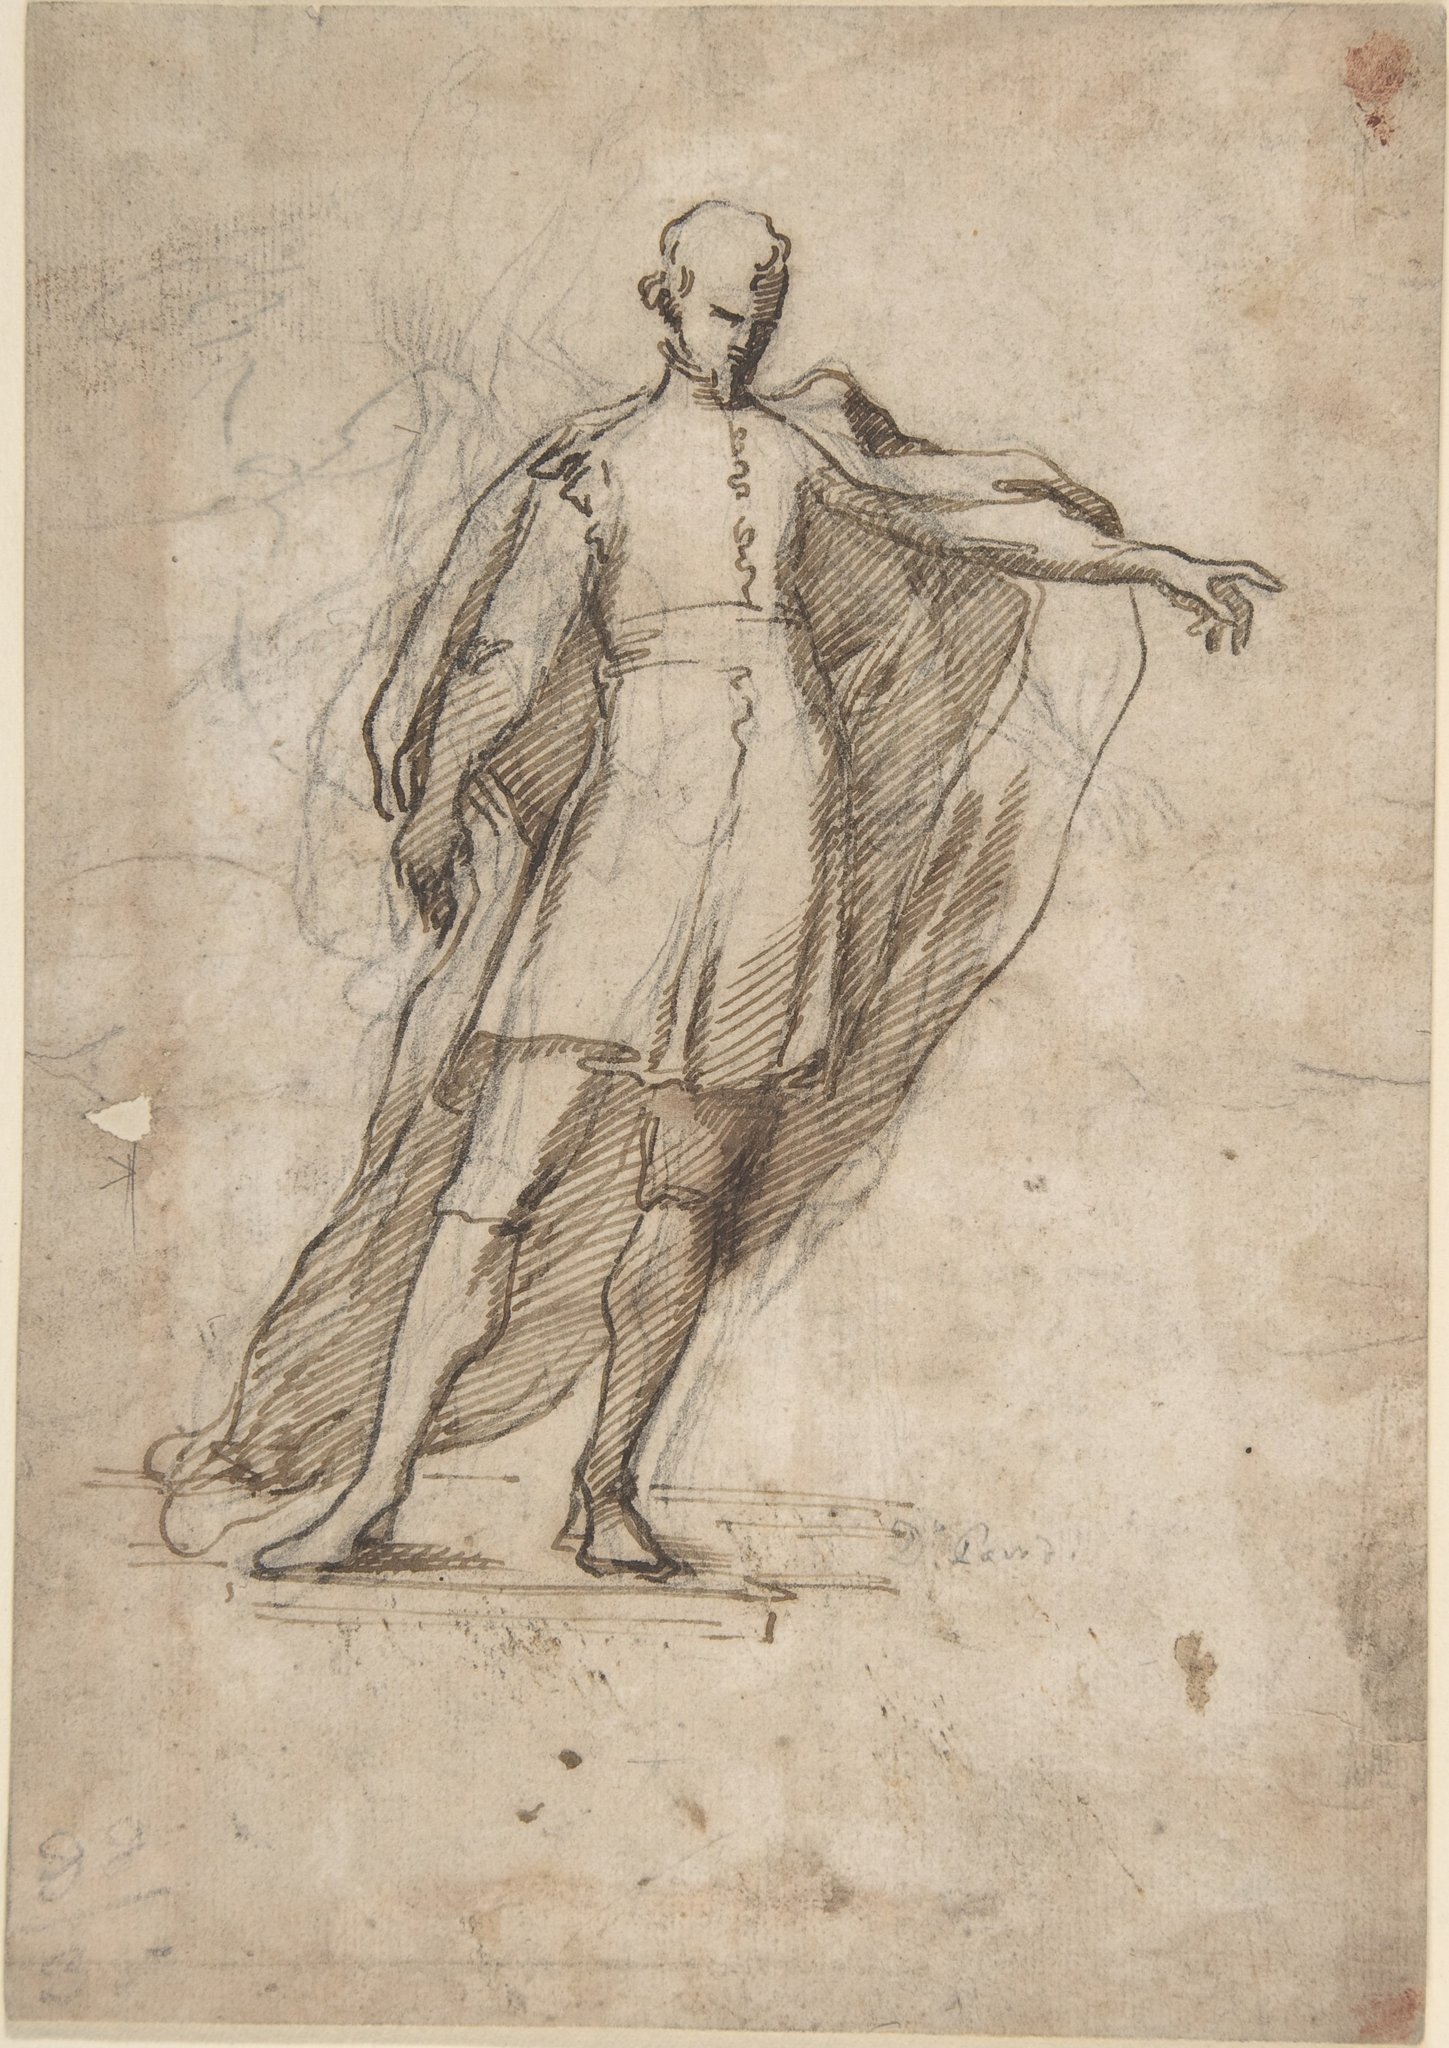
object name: drawing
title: Sketch of a Standing Male Figure Wearing a Cape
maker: anonymous, italian, early 19th century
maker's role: artist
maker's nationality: italian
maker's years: 1800-1825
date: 1800-1900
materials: chalk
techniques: pen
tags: men